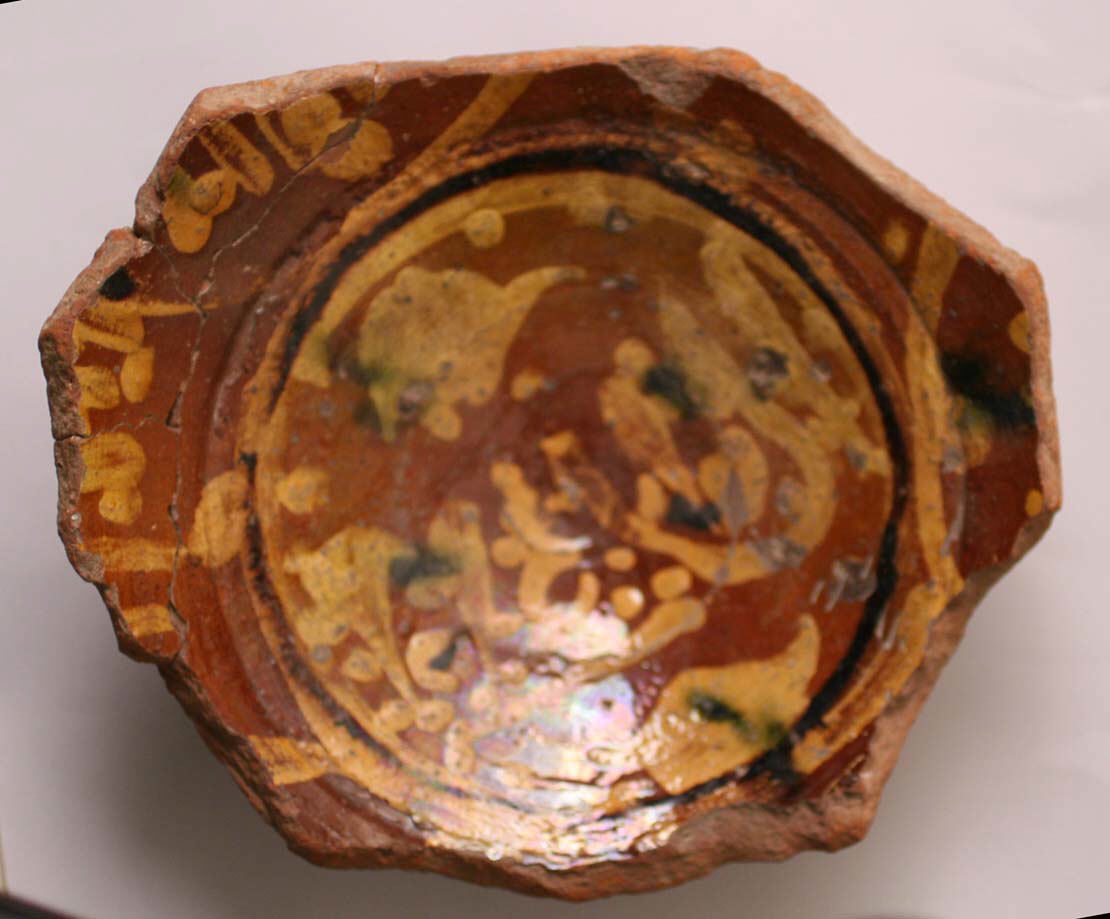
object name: ceramic fragment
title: Fragment of a Bowl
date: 1301-1500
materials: earthenware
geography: egypt or syria